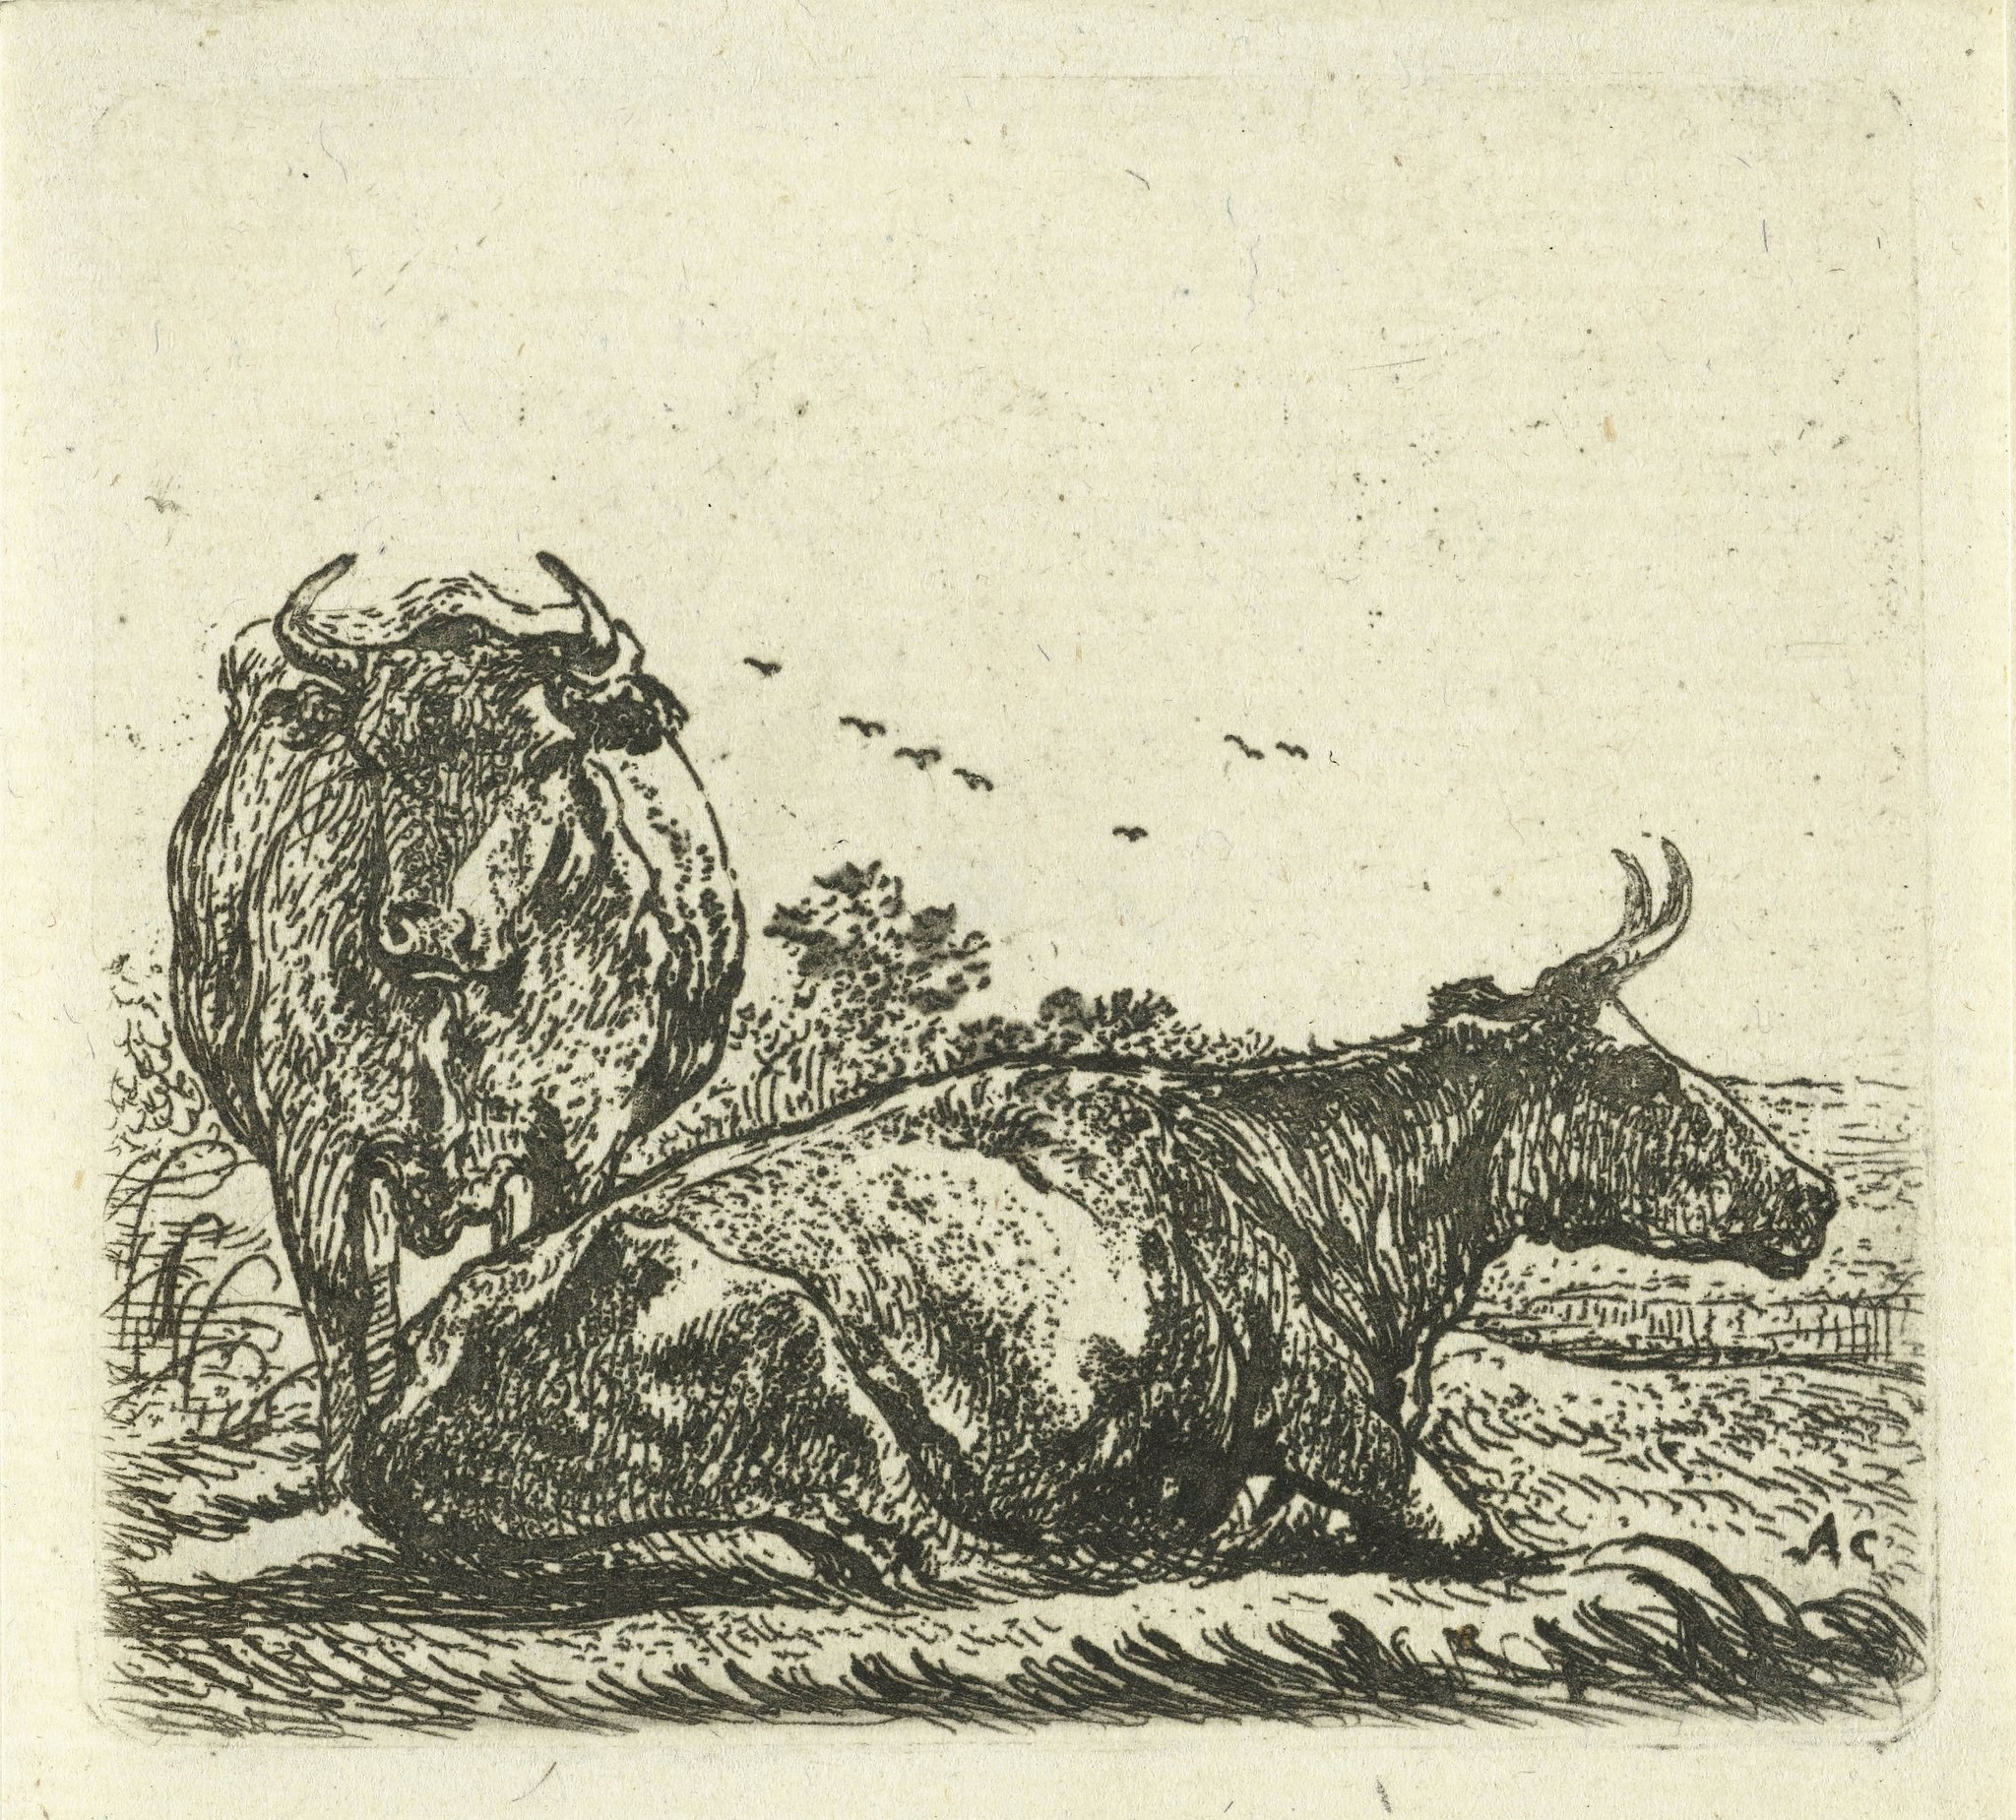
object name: print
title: Twee koeien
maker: aelbert cuyp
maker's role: draughtsman, painter, print maker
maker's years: 1620-1691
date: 1630-1691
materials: paper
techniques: etching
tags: cow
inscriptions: collector's mark: Lugt 2228, collector's mark: ‘FR’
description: Prent uit serie van zes prenten met koeien. Bij de derde staat werd door een anonieme vervaardiger een titelprent aan de serie toegevoegd.